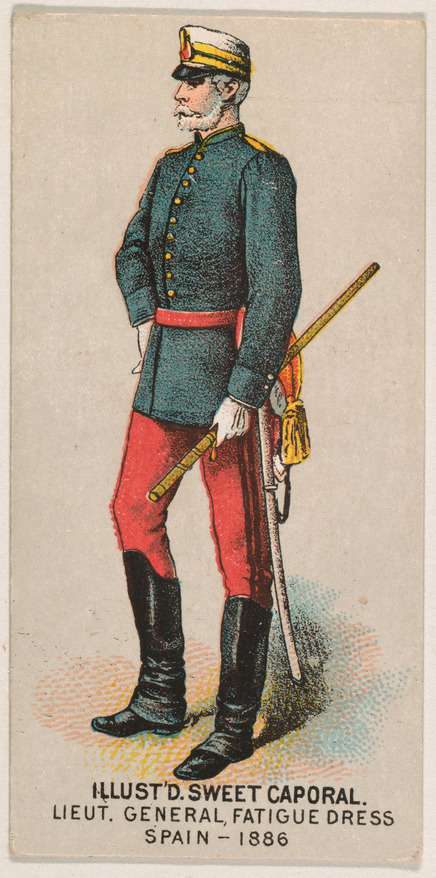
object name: print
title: Fatigue Dress, Lieutenant General, Spain, 1886, from the Military Series (N224) issued by Kinney Tobacco Company to promote Sweet Caporal Cigarettes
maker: kinney brothers tobacco company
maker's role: publisher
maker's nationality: american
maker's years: 1869-2011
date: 1888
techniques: color lithograph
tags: men,profiles,generals